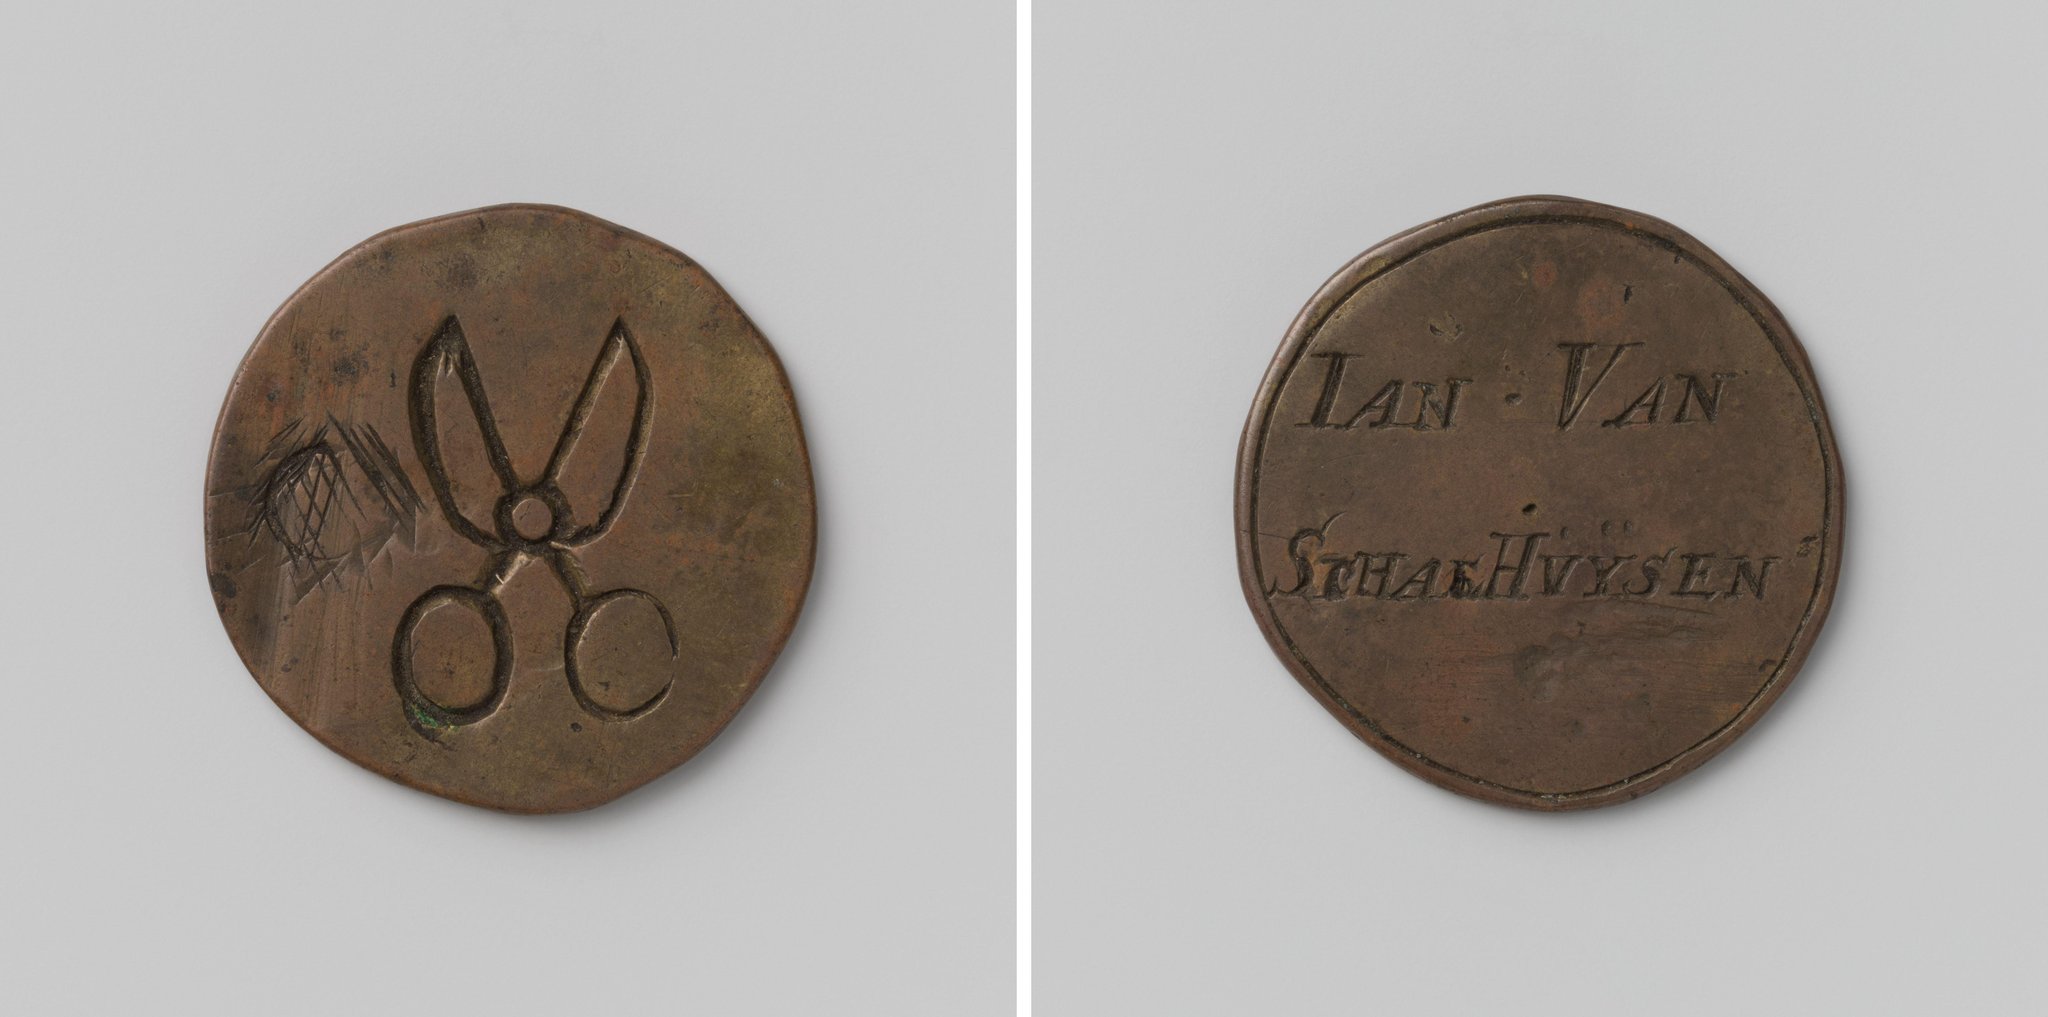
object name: medal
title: Kleermakersgilde van Amsterdam, gildepenning van Jan van Schathuysen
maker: Anonymous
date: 1710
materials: brass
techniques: engraving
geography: amsterdam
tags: amsterdam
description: Messing penning. Voorzijde: geopende schaar; links daarvan rest van letter O [?], waar overheen gekrast is. Keerzijde: opschrift